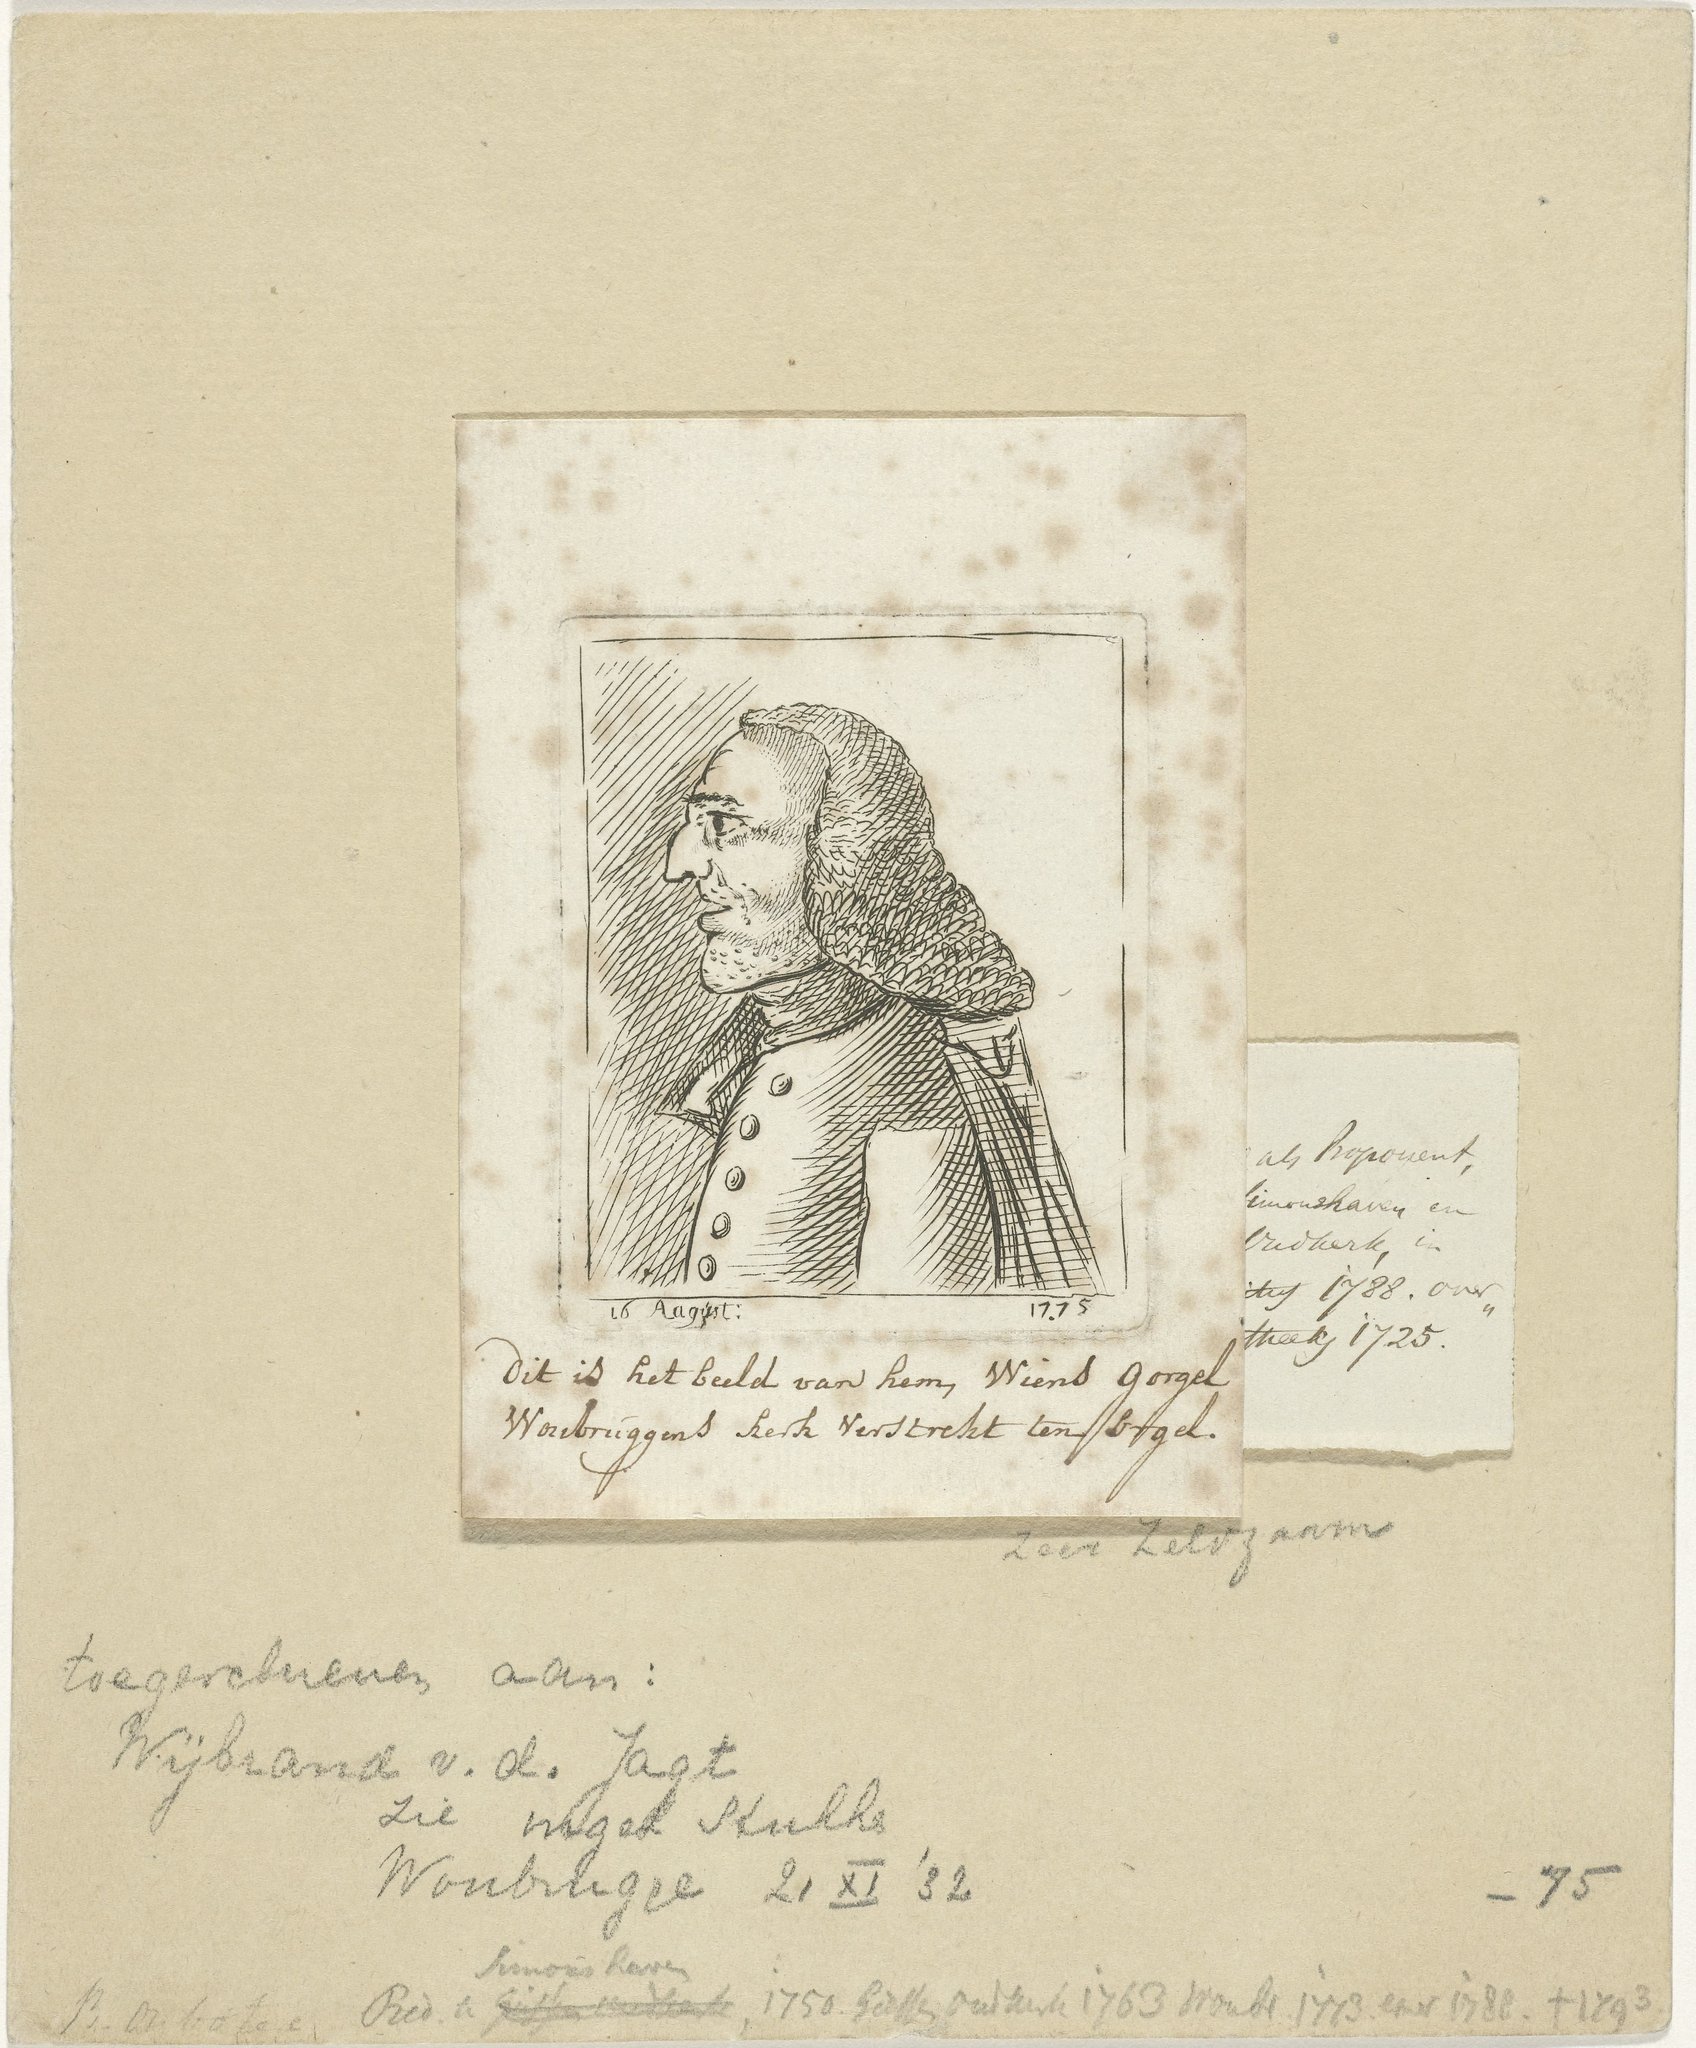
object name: print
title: Portret van Bartholomeus Ouboter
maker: wijbrand van der jagt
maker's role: print maker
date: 1775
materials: paper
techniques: engraving, etching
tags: bartholomeus ouboter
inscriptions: collector's mark: Lugt 2228, inscription: ‘Dit is het beeld van hem, Wiens gorgel Woubruggens kerk verstrekt ten [?]’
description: Bij de prent is op een apart blad op het opzetblad een vijfregelige tekst in Nederlands over de functie van de geportretteerde toegevoegd.